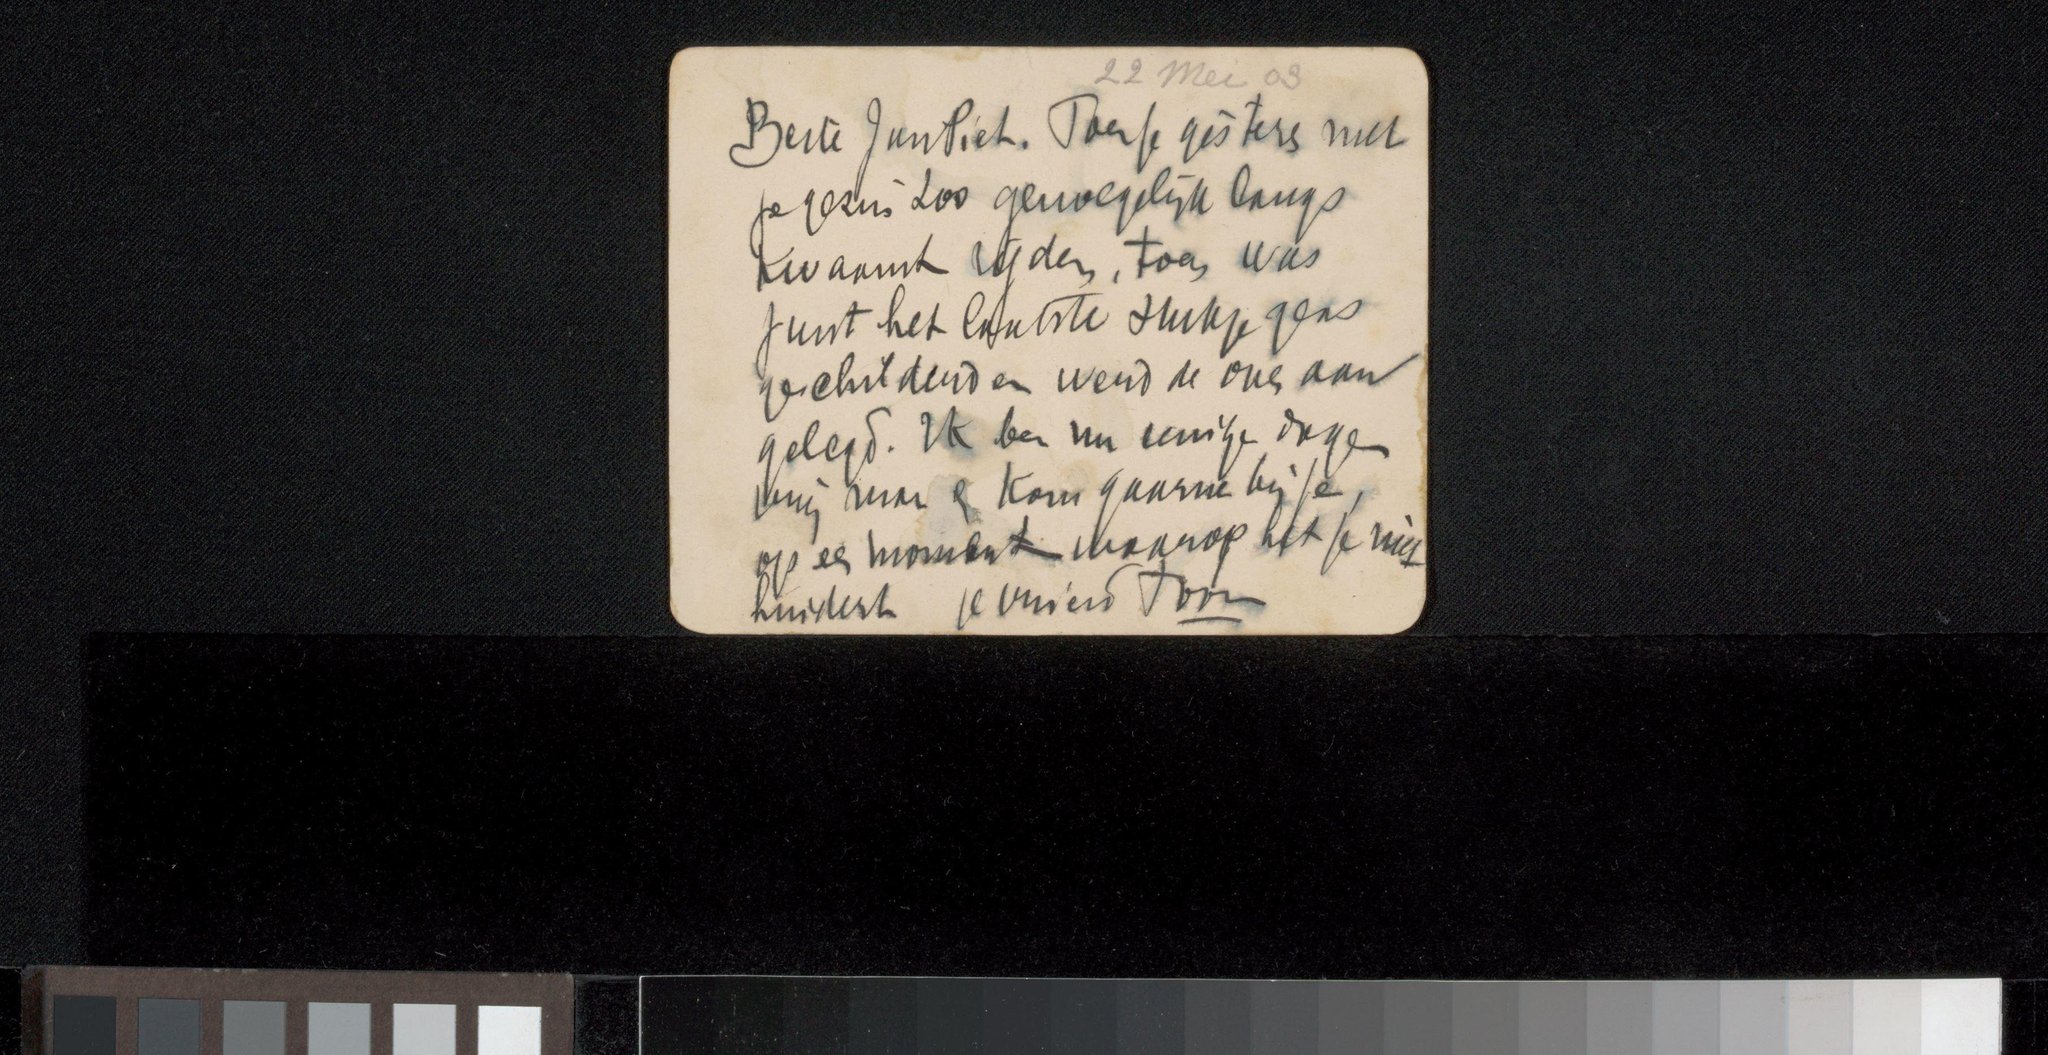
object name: letter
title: Brief aan Jan Veth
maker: antoon derkinderen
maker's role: draughtsman, painter, print maker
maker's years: 1859-1925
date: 1874-1925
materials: cardboard, ink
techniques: pen, writing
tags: dordrecht, amsterdam, painter, print maker, draughtsman, designer, jan veth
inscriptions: collector's mark: ‘RPK’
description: Brief gedateerd 22 Mei 03 in latere hand.